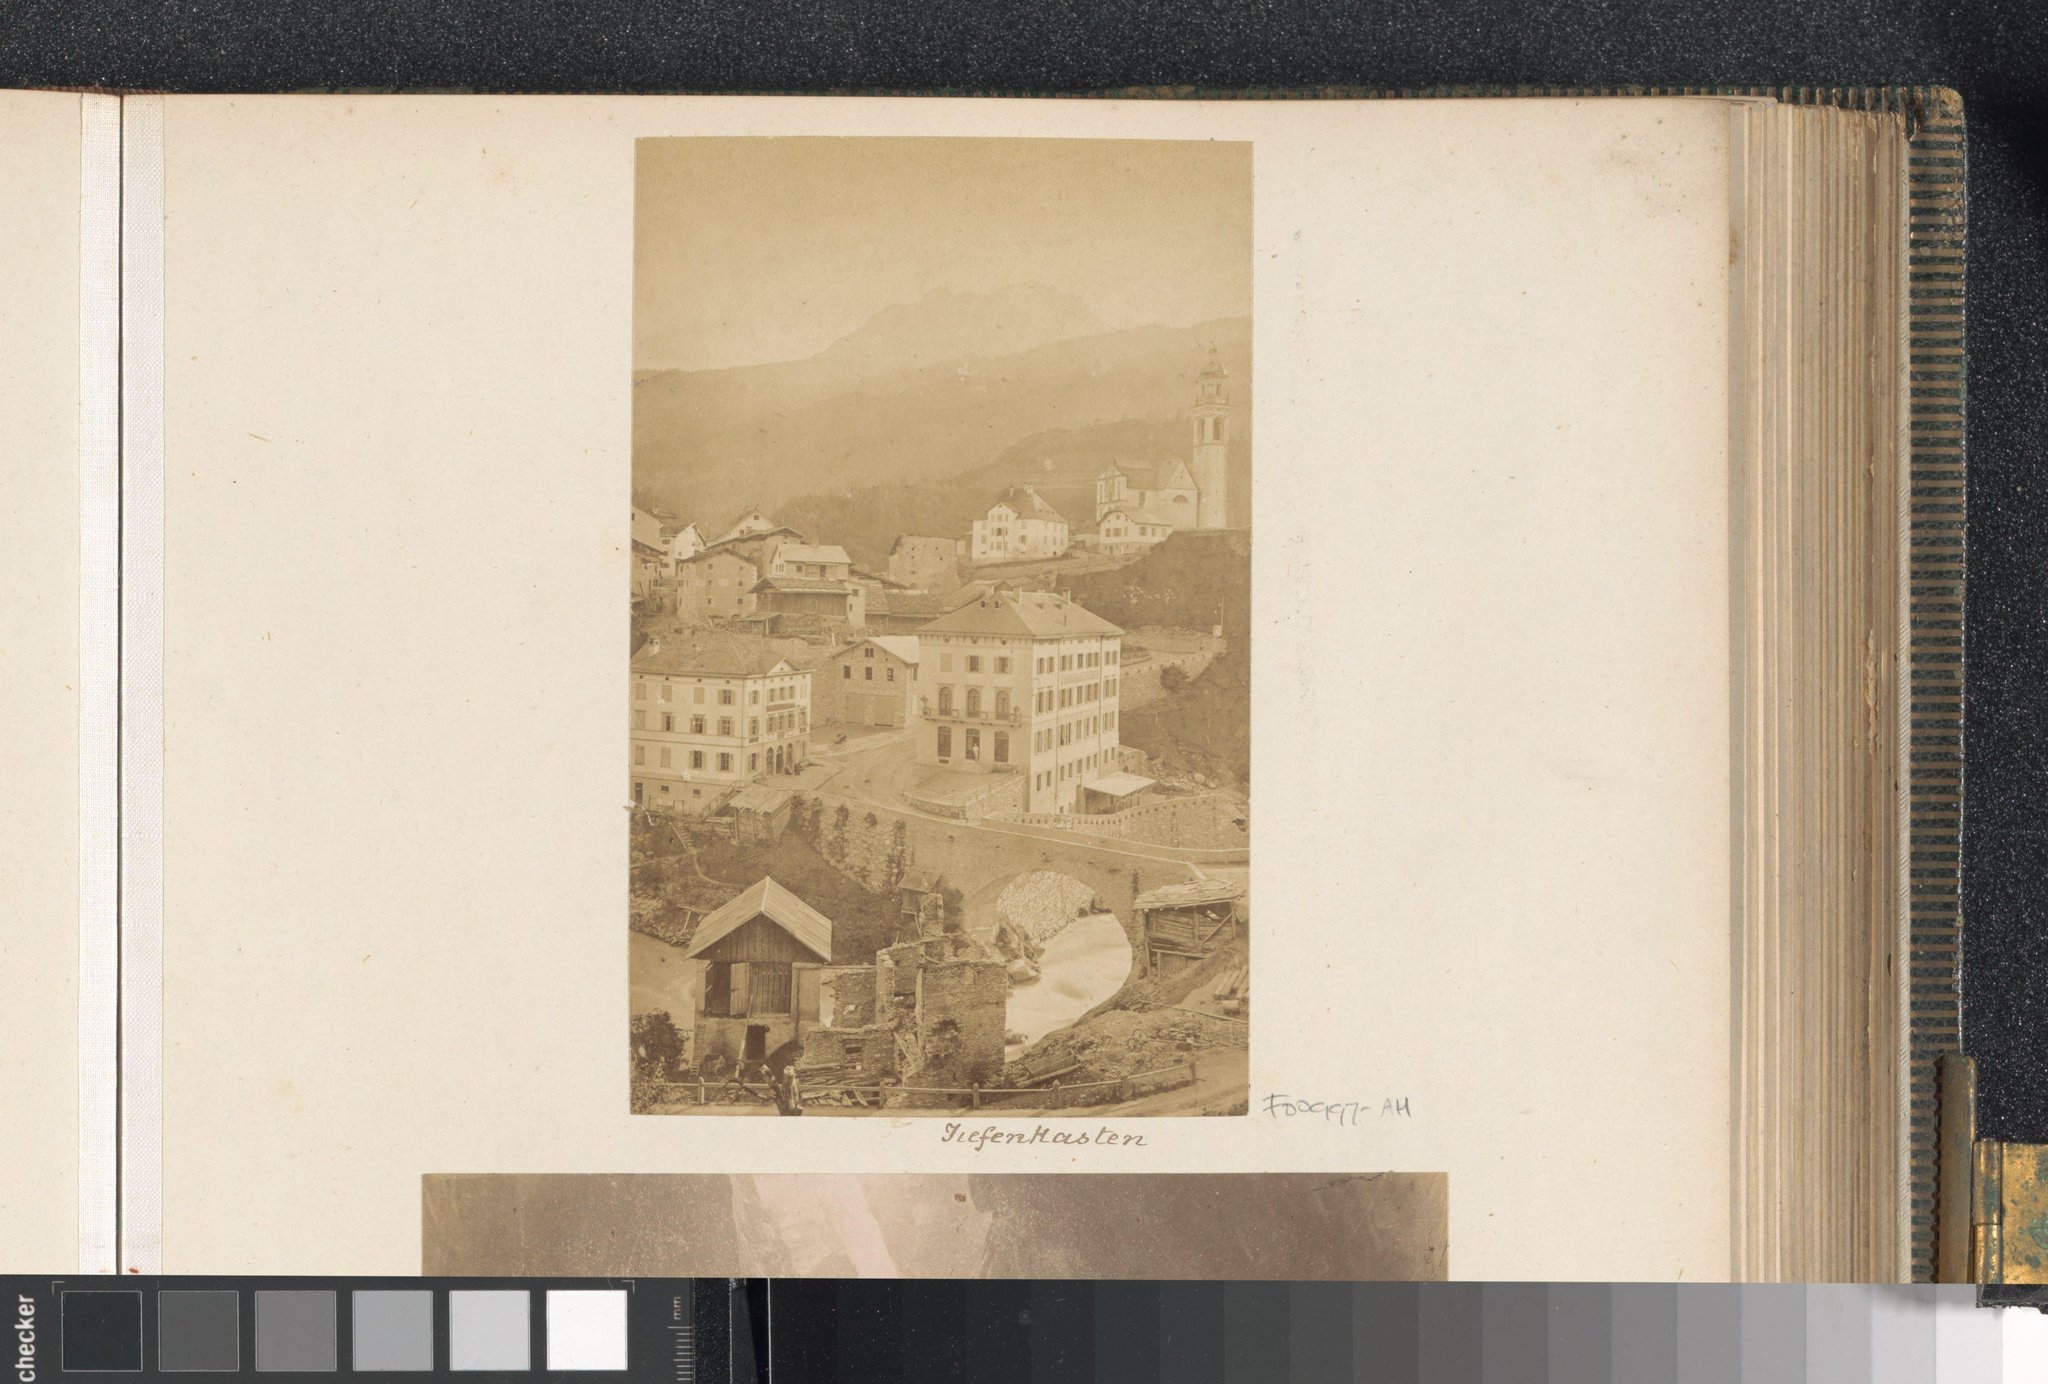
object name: photograph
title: Tiefenhasten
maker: Anonymous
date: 1860-1890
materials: paper, photographic support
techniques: albumen print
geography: switzerland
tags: prospect of village, silhouette of village, switzerland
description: Onderdeel van Reisalbum met foto's van Zwitserland, Oostenrijk, Italië en Duitsland.